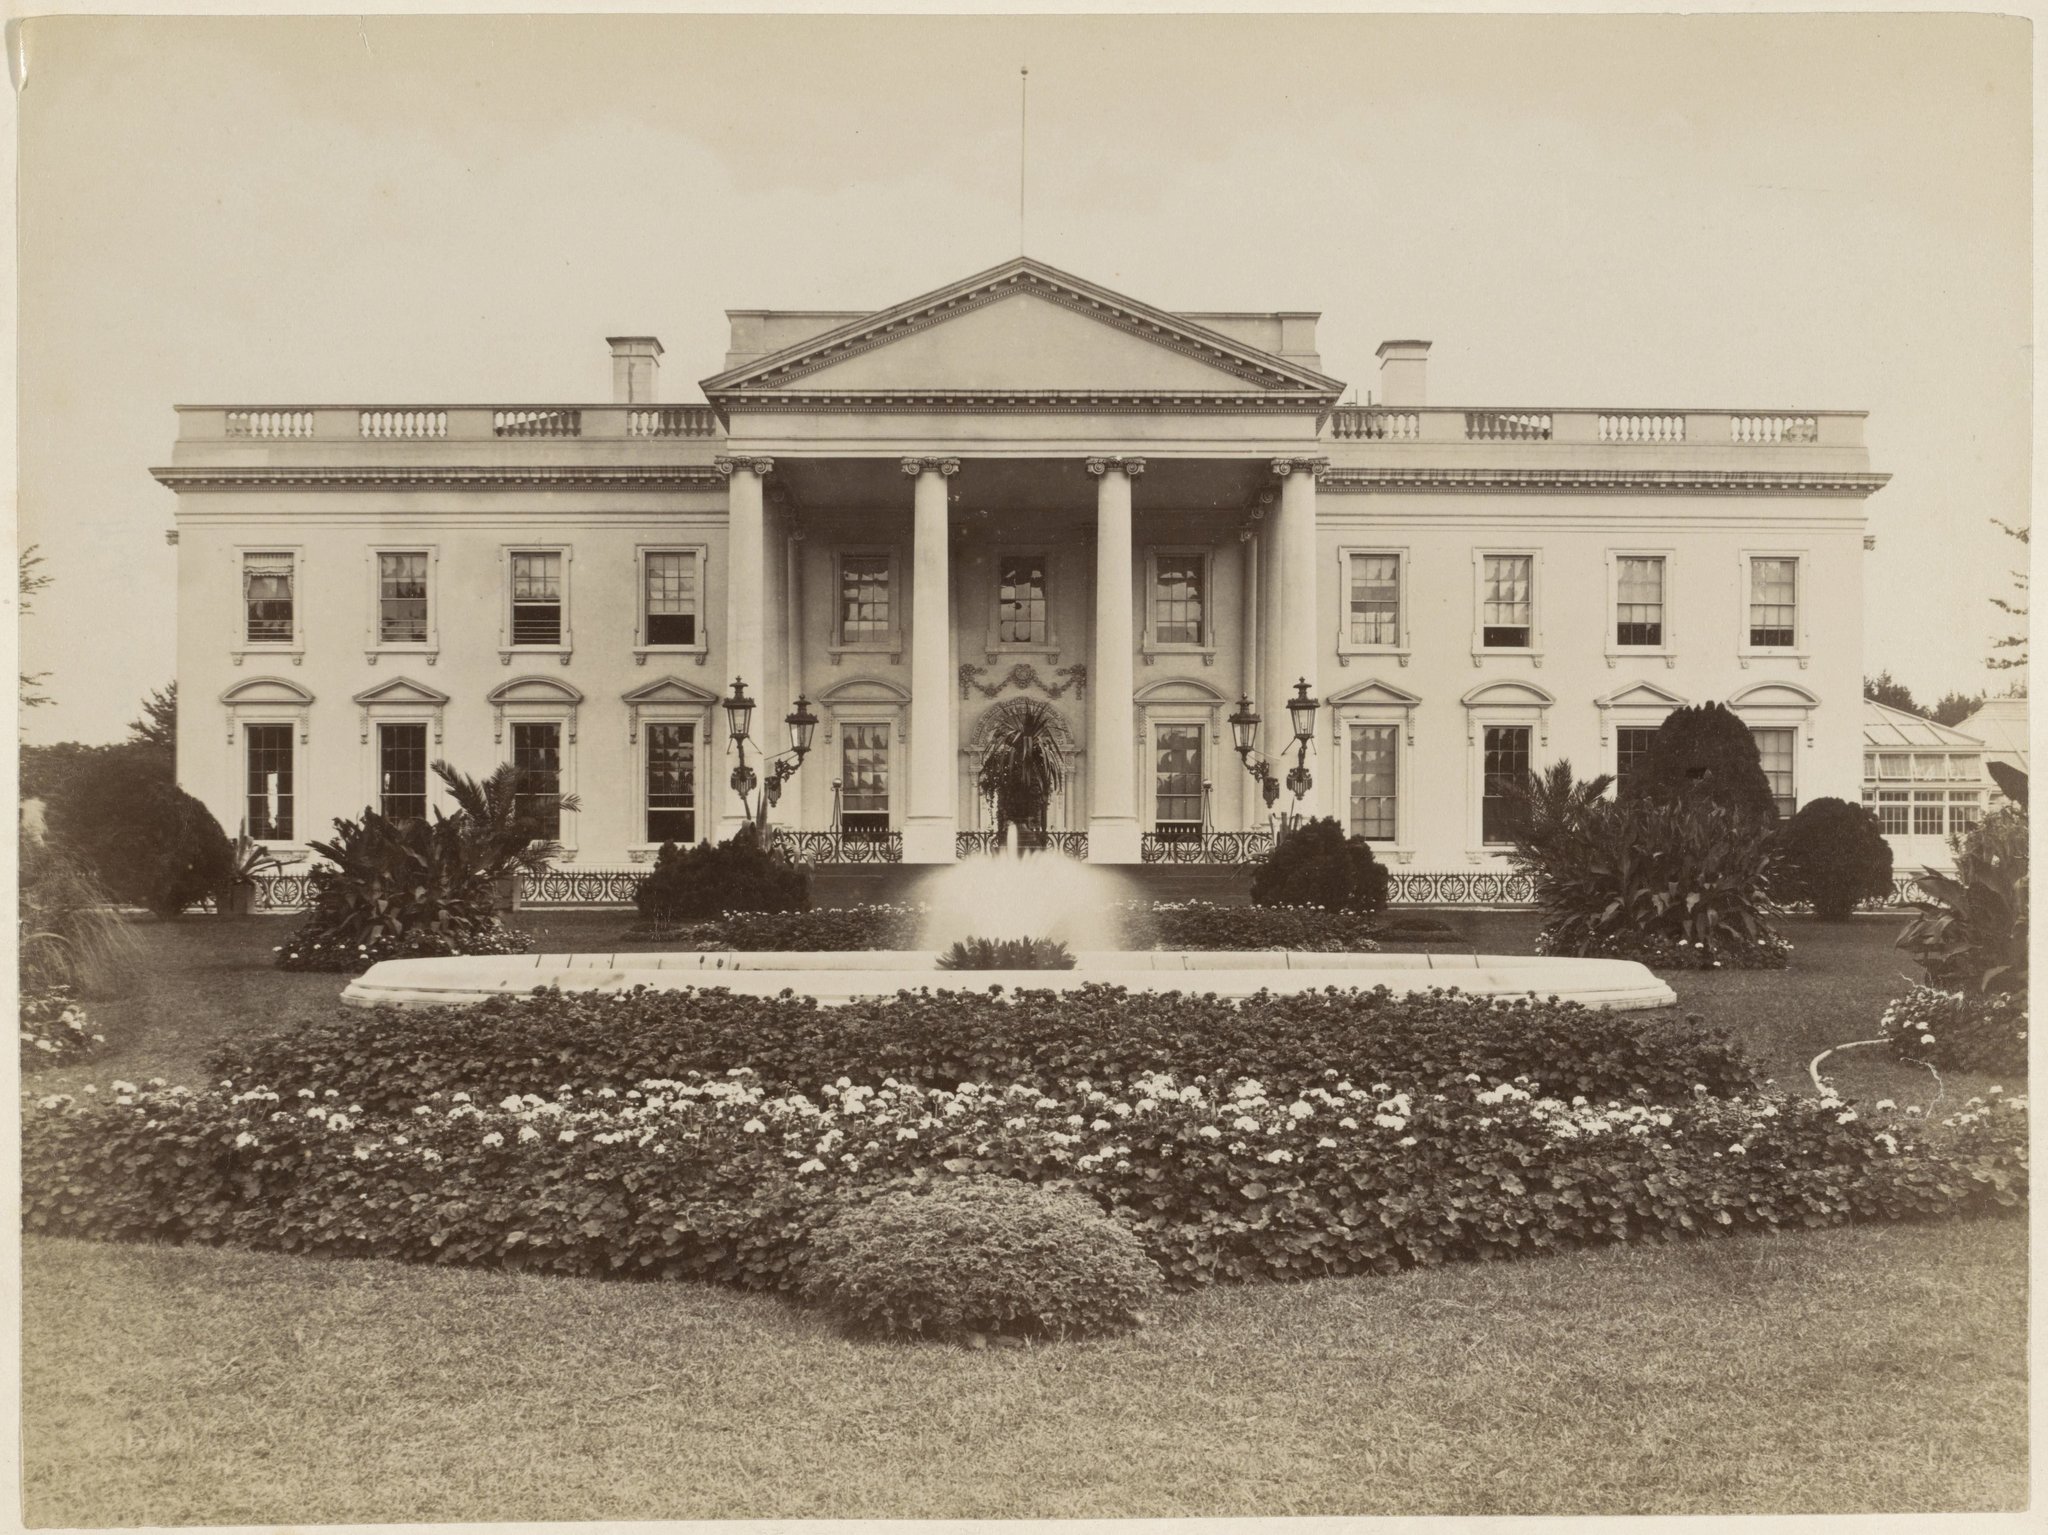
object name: photograph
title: White house (Washington)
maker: Anonymous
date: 1880-1900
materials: cardboard, paper, photographic support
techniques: albumen print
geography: washington d.c.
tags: façade (of house or building)